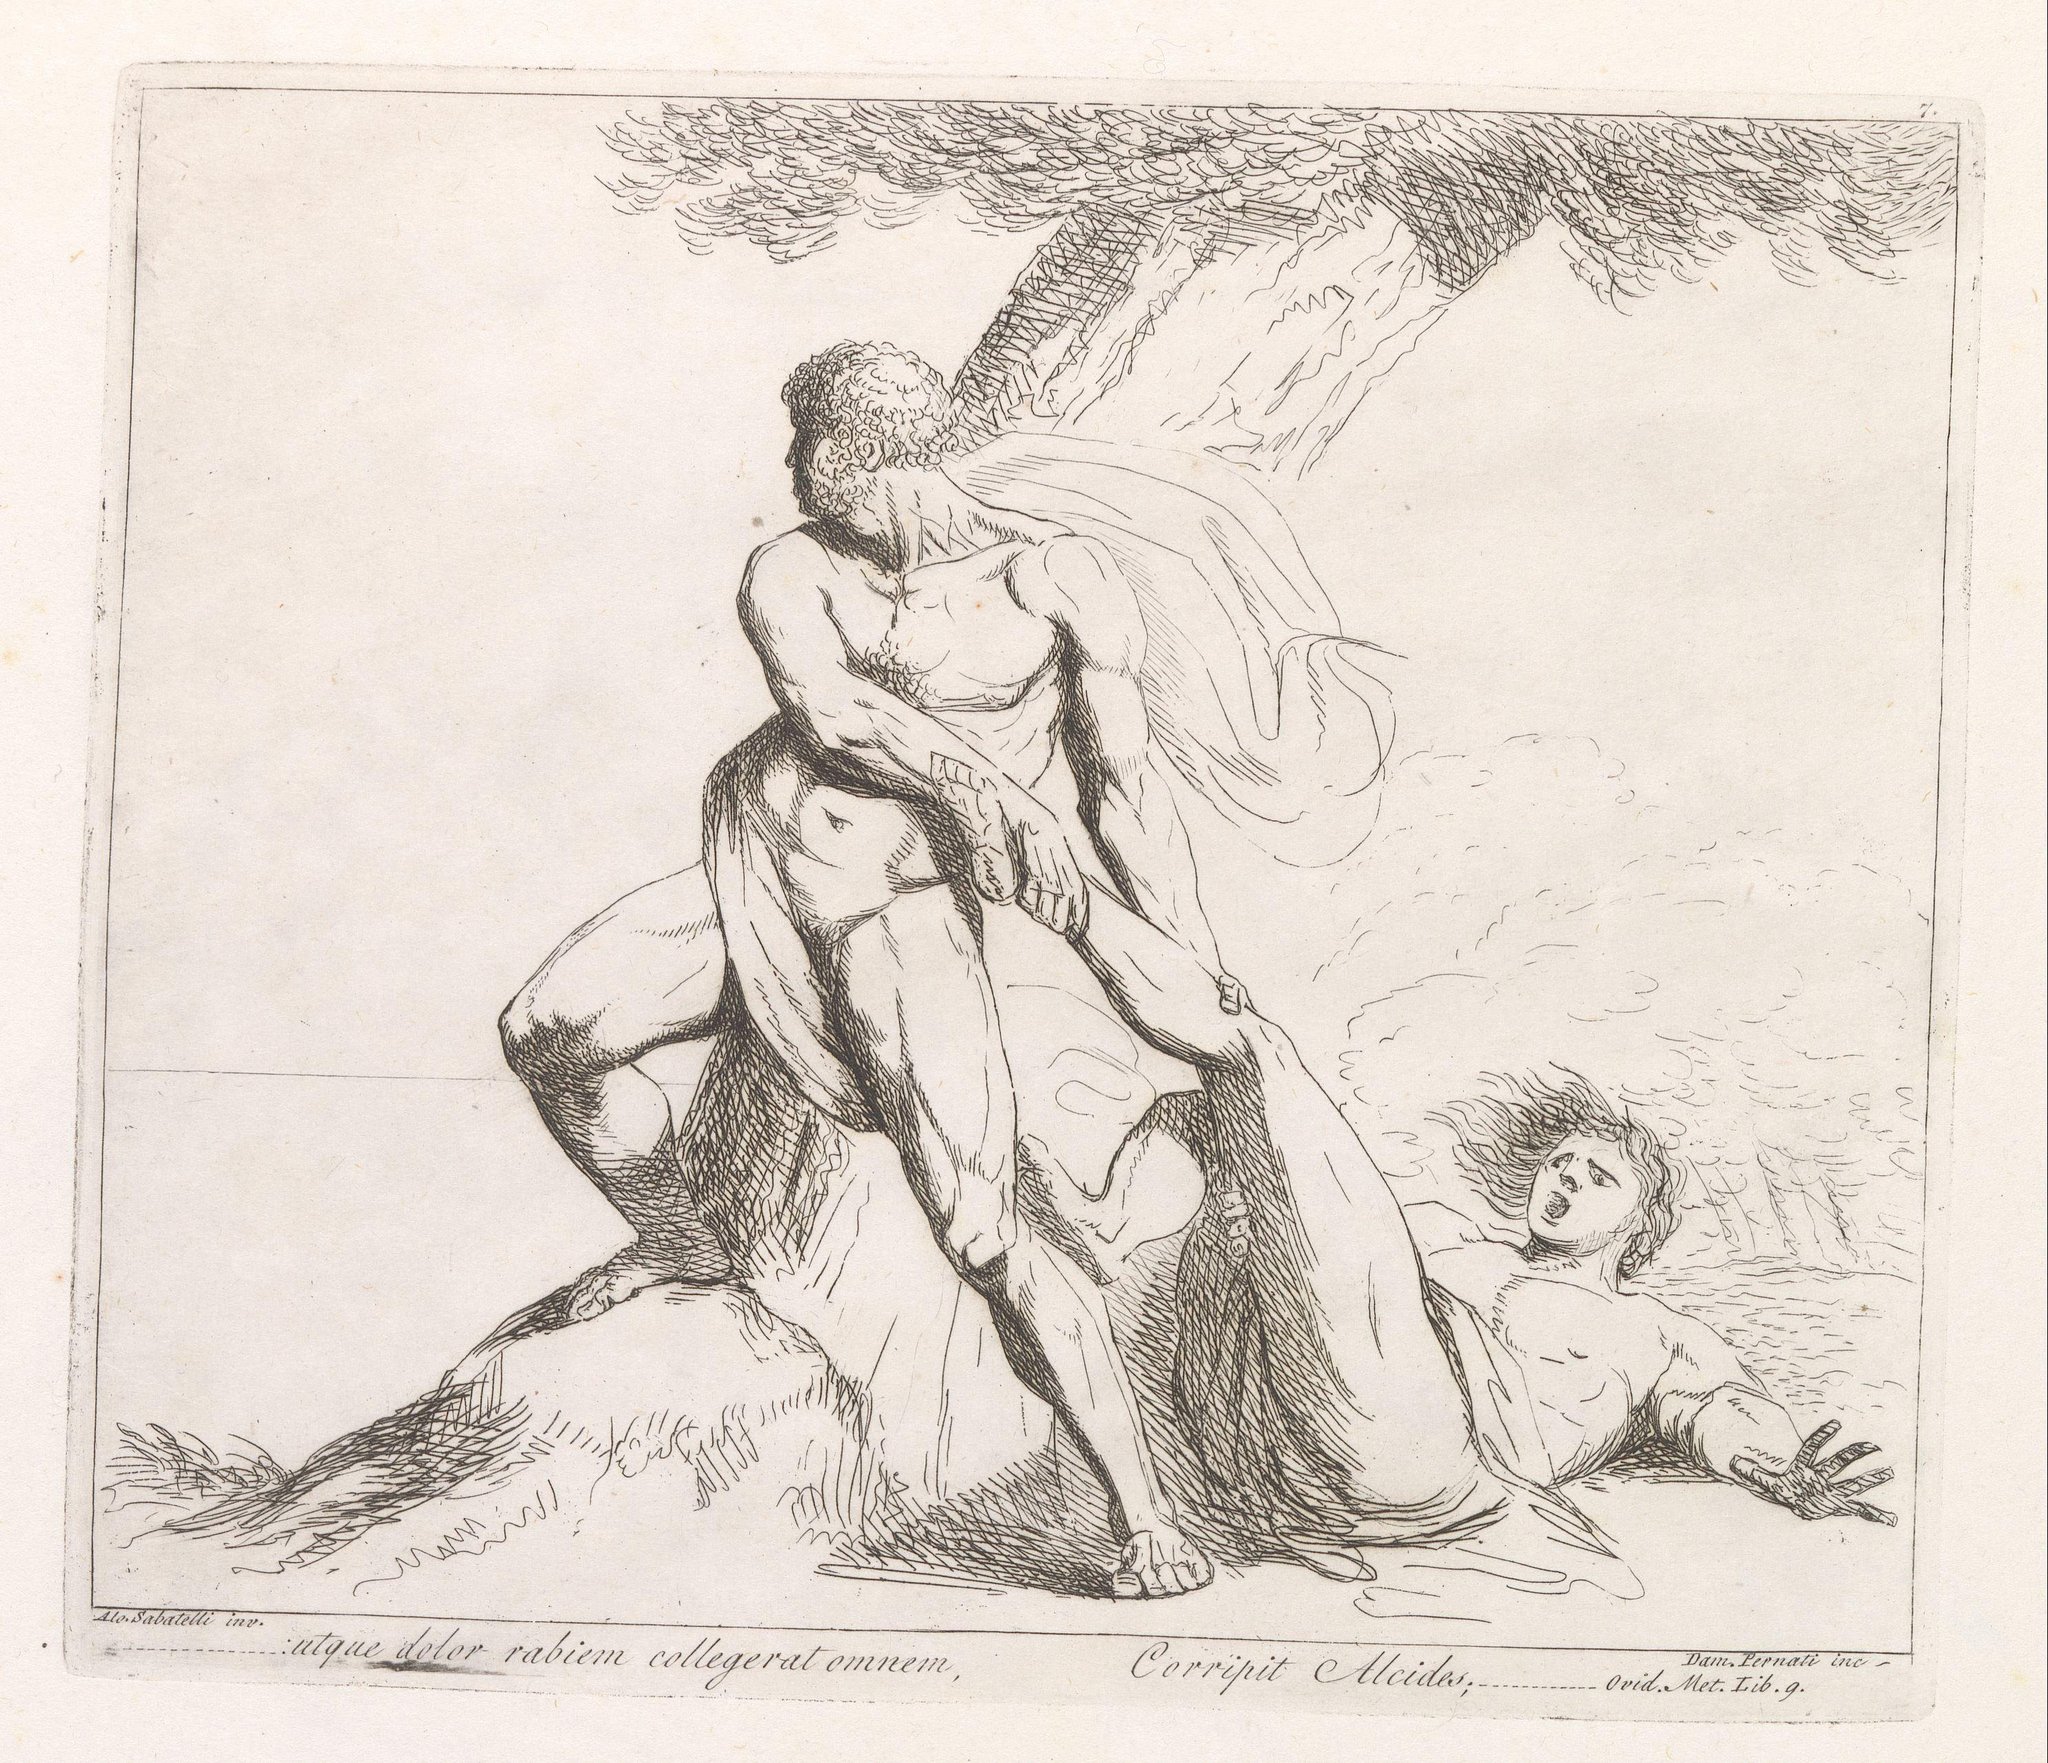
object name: print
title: Hercules en Lichas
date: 1804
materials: paper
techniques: etching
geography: italy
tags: hercules, raging with pain, hurls lichas into the sea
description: Hercules en Lichas. Prent nr. 7 op blad 5 in het album 'Raccolta di Soggetti Pittorici', een prentalbum met 42 genummerde etsen op 28 pagina's van Luigi Sabatelli (I) zelf en van leerlingen naar diens ontwerp.